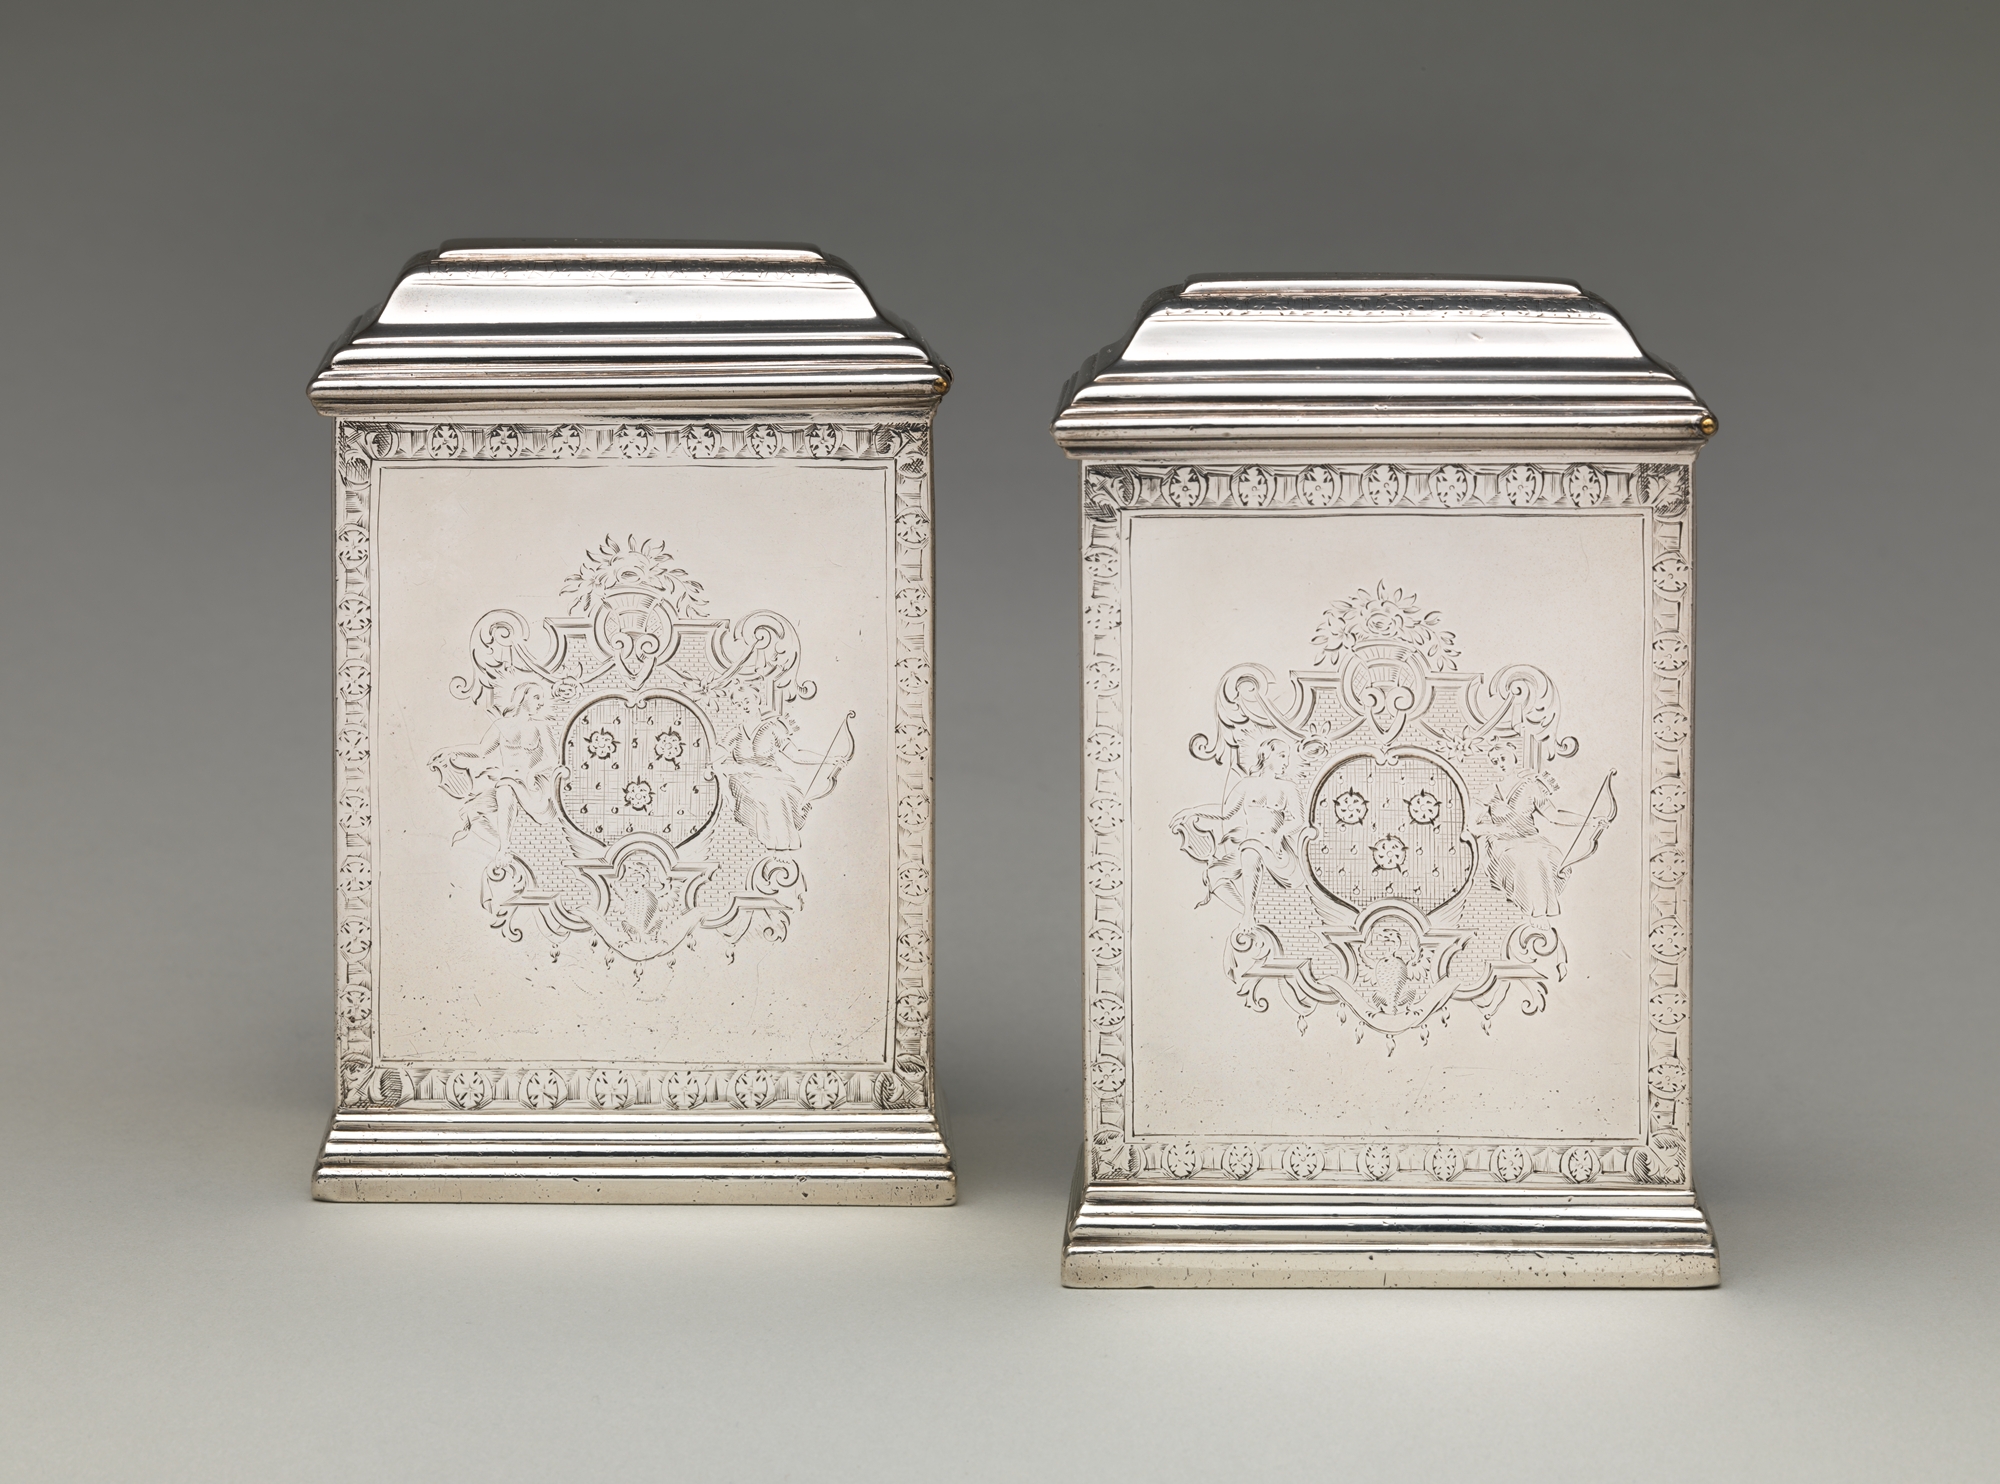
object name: tea caddy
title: Tea caddy (one of a pair)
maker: augustin courtauld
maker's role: maker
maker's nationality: british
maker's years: 1685-1751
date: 1726-1727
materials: silver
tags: coat of arms